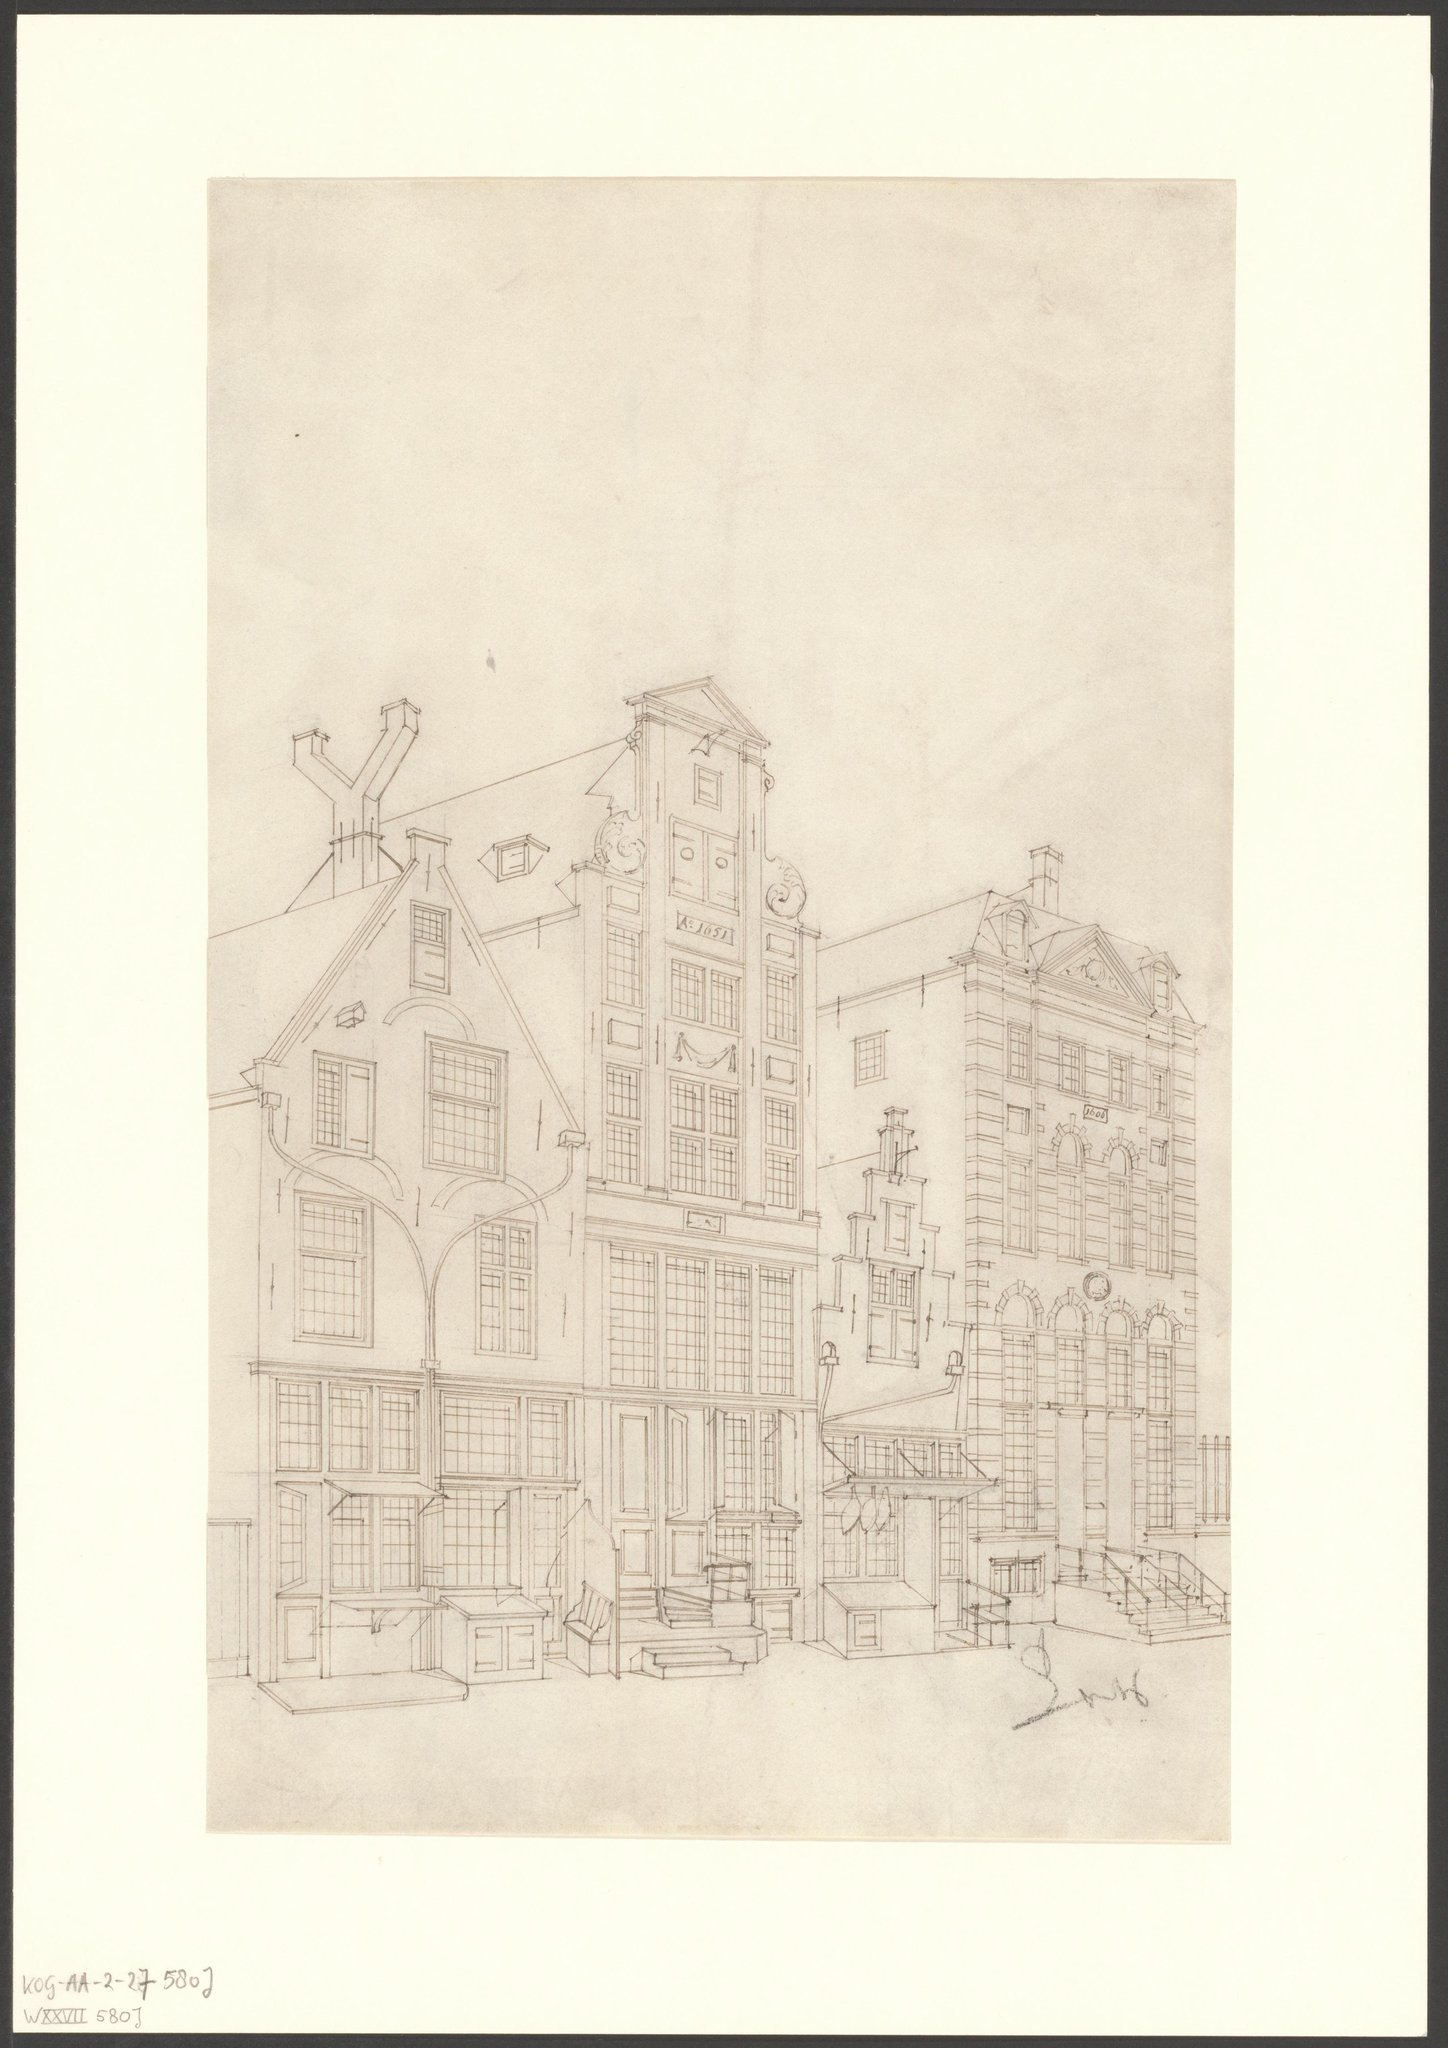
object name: drawing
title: Gezicht op Oud-Holland tijdens de Wereldtentoonstelling voor het Hotel- en Reiswezen in 1895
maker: evert breman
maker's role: architect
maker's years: 1859-1926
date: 1894-1895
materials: ink, paper, pencil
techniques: pen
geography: amsterdam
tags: city-view in general; 'veduta', village, façade (of house or building)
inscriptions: signature: ‘Evert’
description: Tekening binnen de Atlas Van Eck ingedeeld op wijknummer 27.